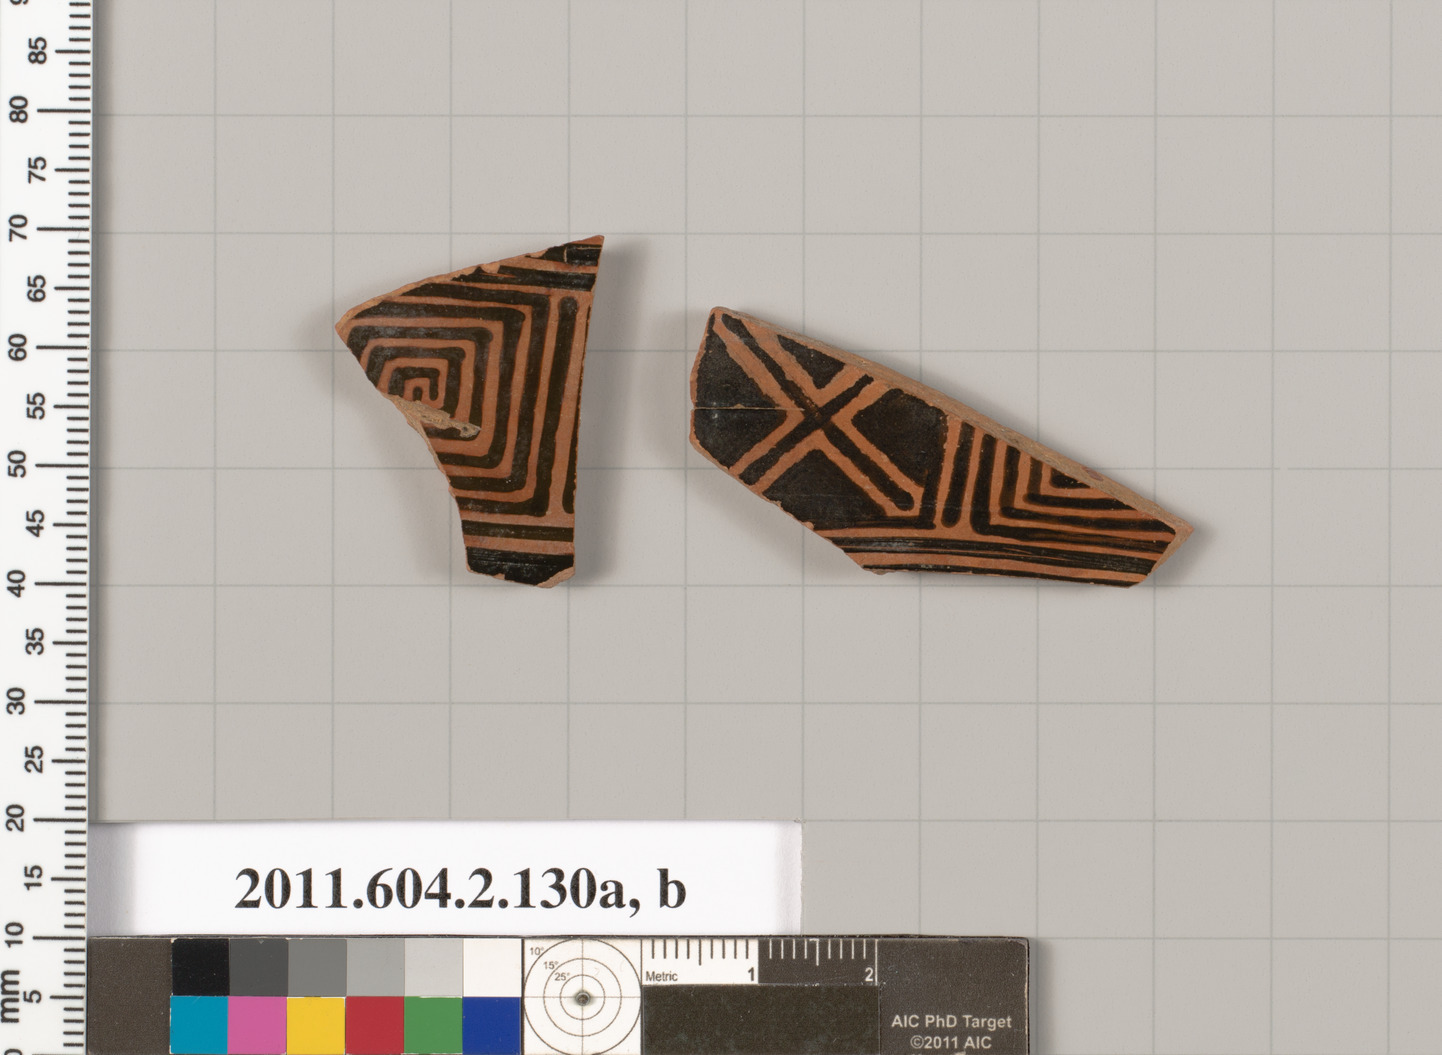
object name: pelike fragment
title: Terracotta fragments of a pelike (jar)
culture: greek, attic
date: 475-451 BCE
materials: terracotta